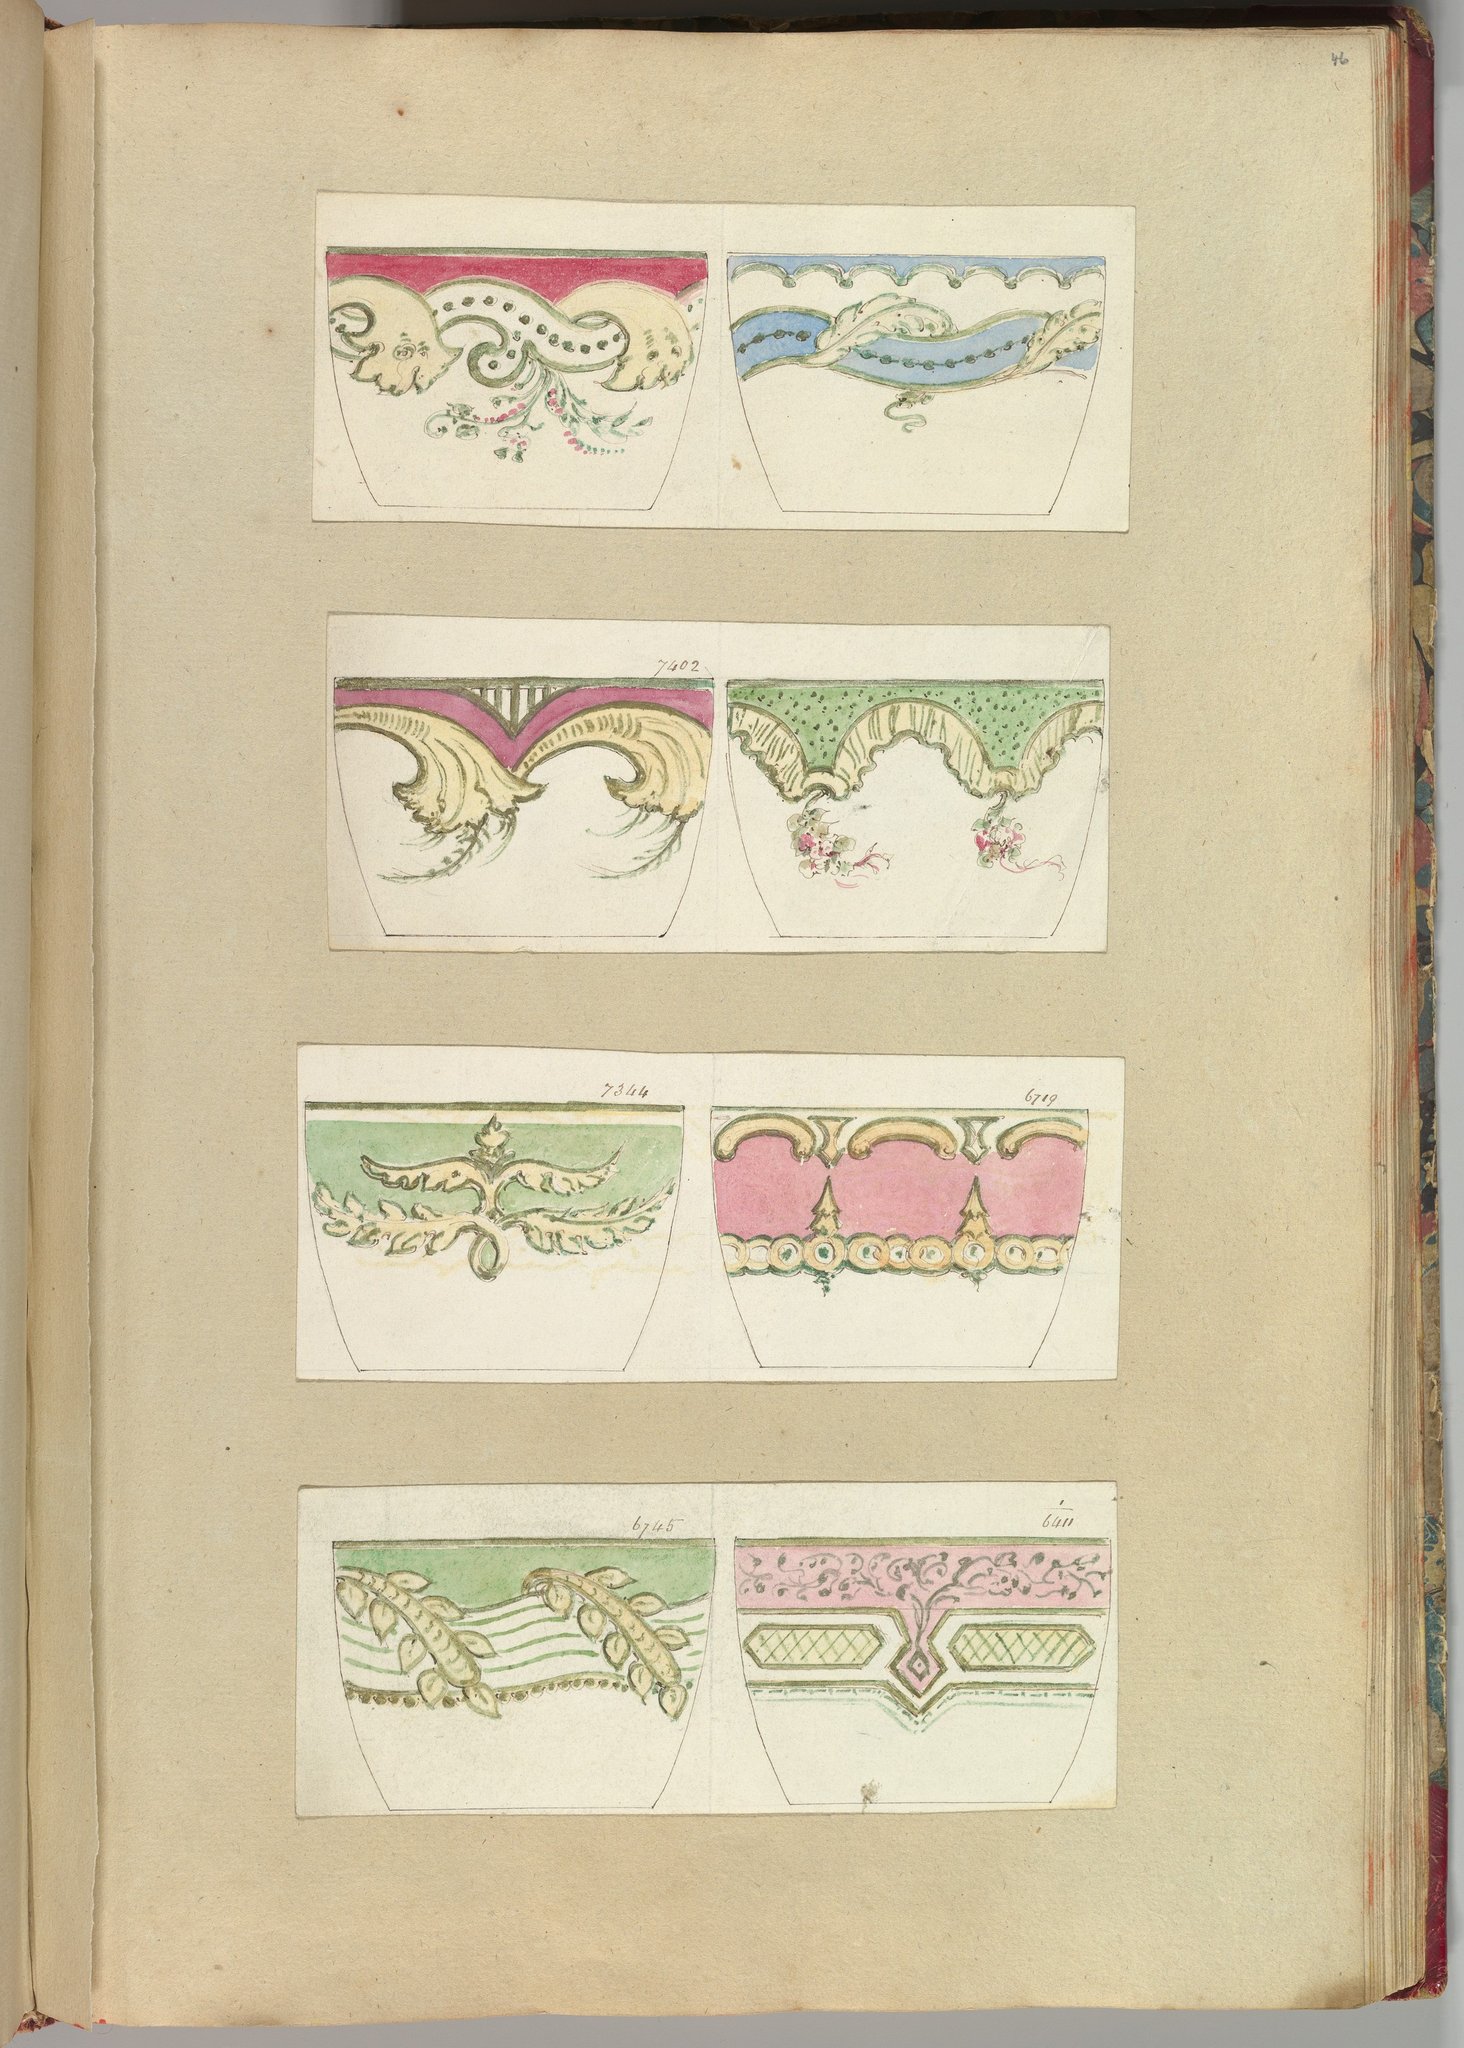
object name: drawing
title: Eight Designs for Decorated Cups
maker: alfred henry forrester [alfred crowquill]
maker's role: artist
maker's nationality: british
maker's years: 1804-1872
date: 1845-1855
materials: ink, watercolor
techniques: pen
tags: cups